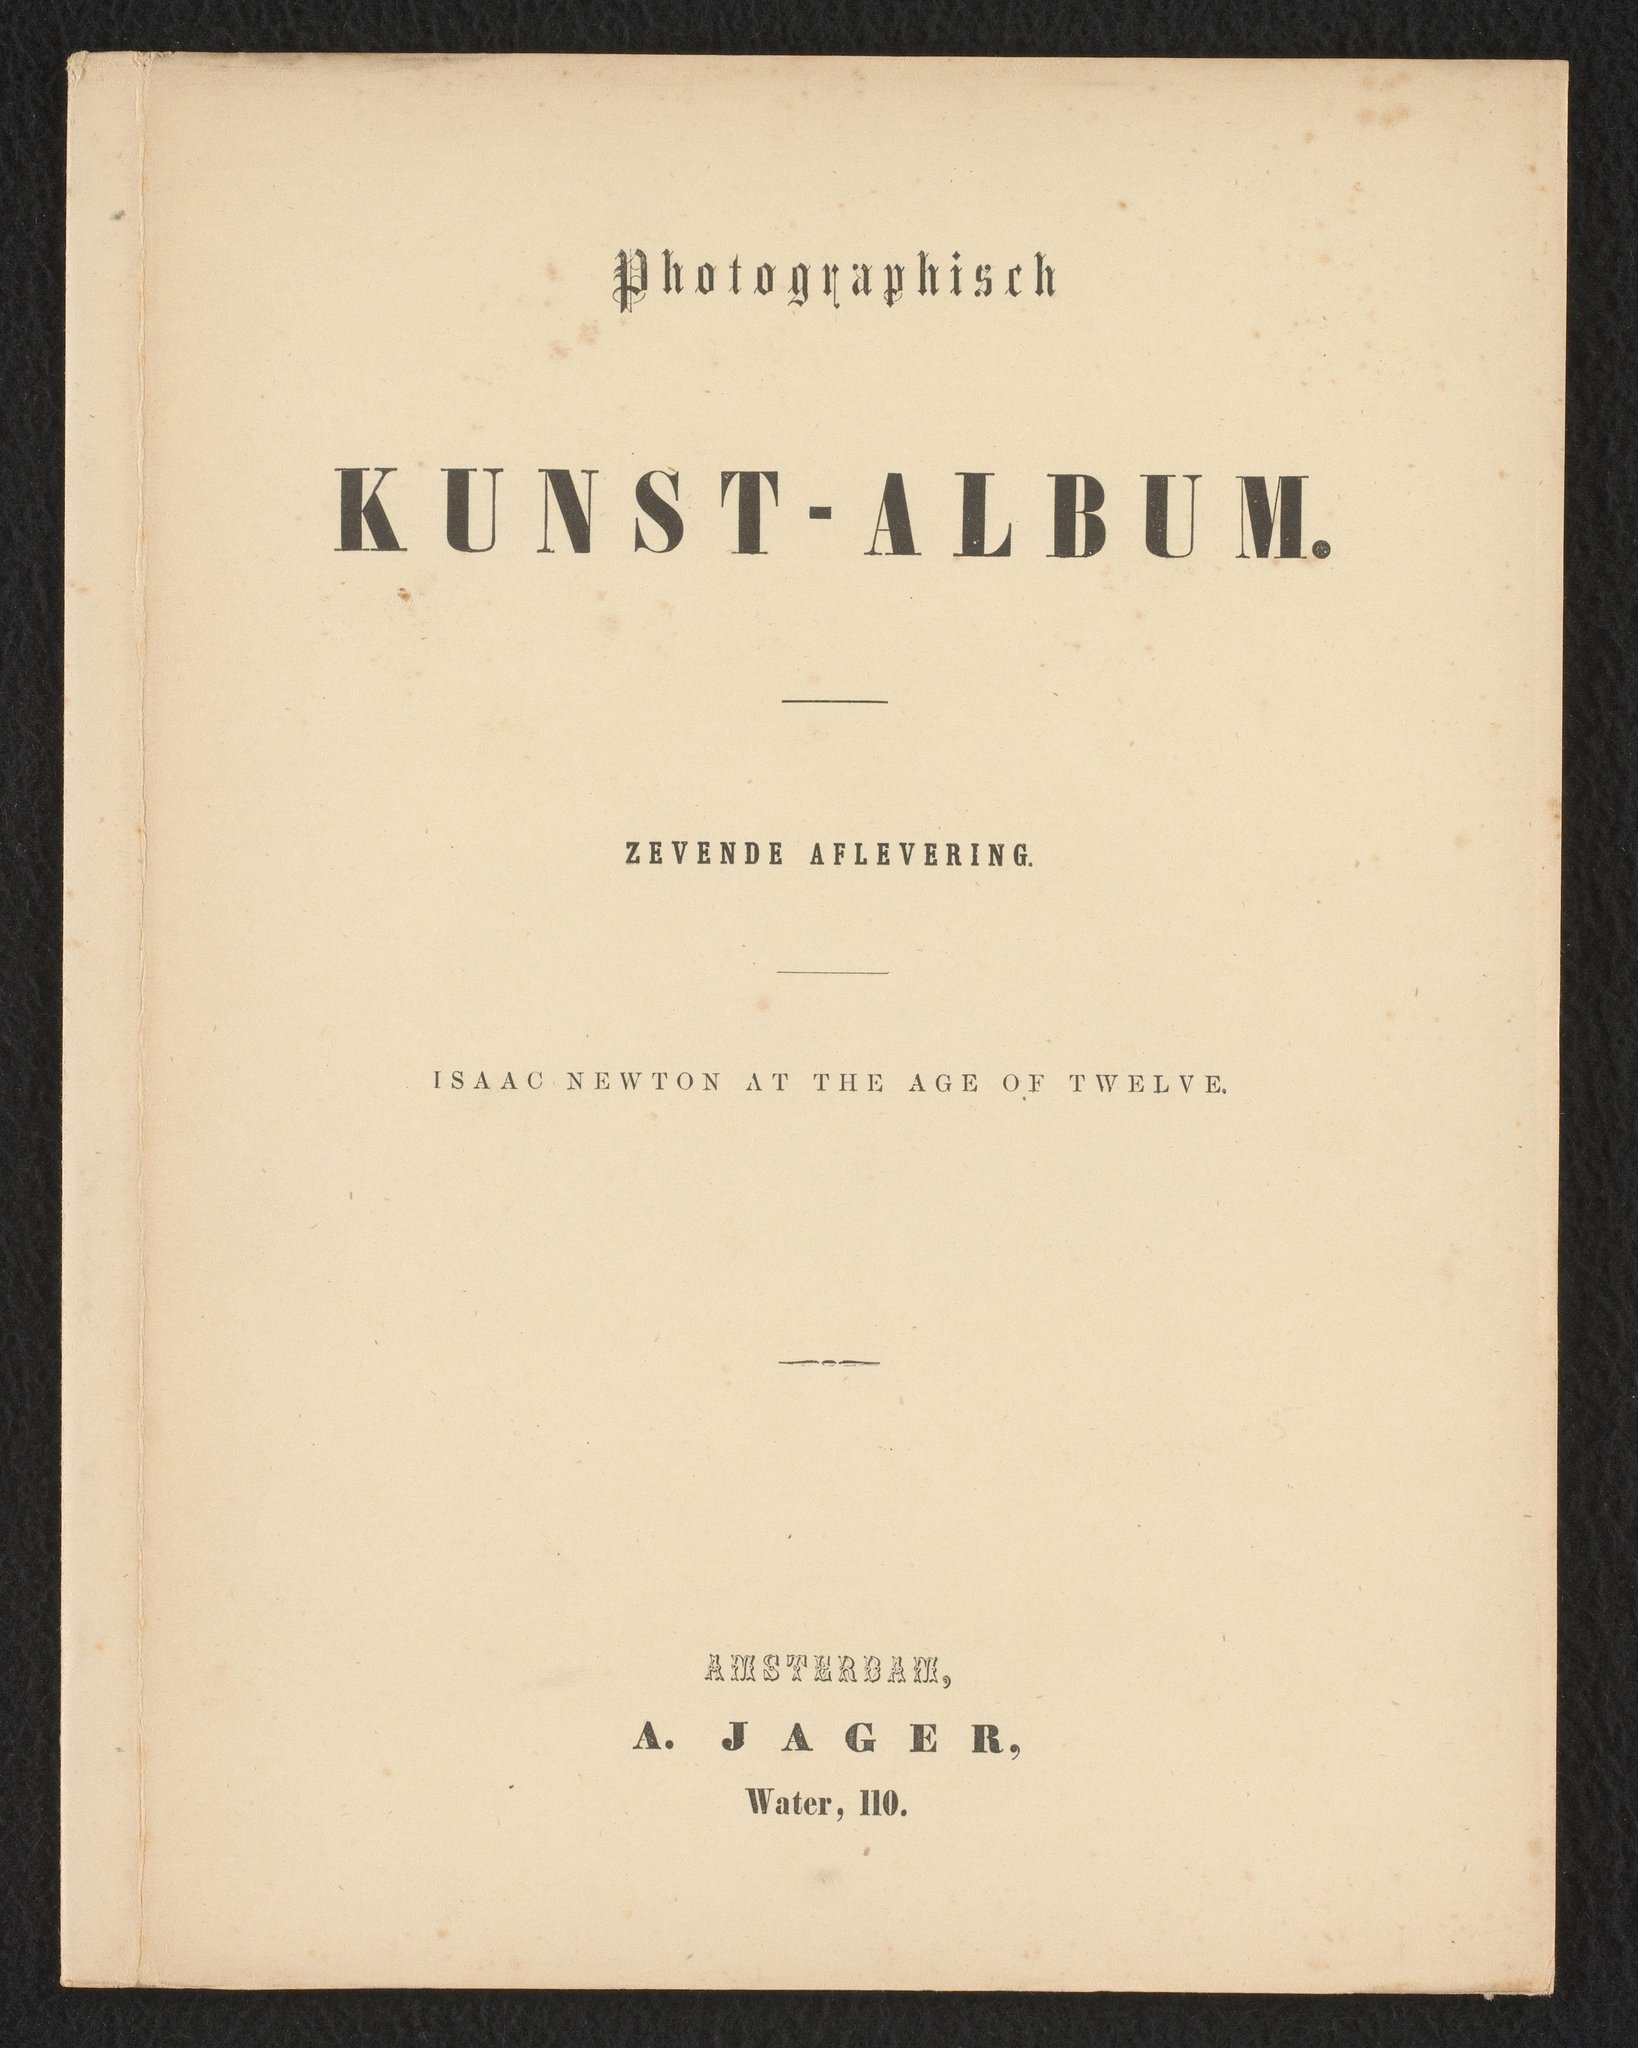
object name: wrapper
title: Zevende aflevering. Isaac Newton at the Age of Twelve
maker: andries jager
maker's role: publisher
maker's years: 1825-1905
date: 1860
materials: paper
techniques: printing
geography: amsterdam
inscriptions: inscription: ‘ISAAC NEWTON AT THE AGE OF TWELVE./ NAAR EENE SCHILDERIJ/ VAN/ FREDERICH NEWENHAM.’, address: ‘AMSTERDAM,/ A. JAGER,/ Water, 110.’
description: Deze omslag maakt deel uit van een omslag met twaalf fotoreproducties.